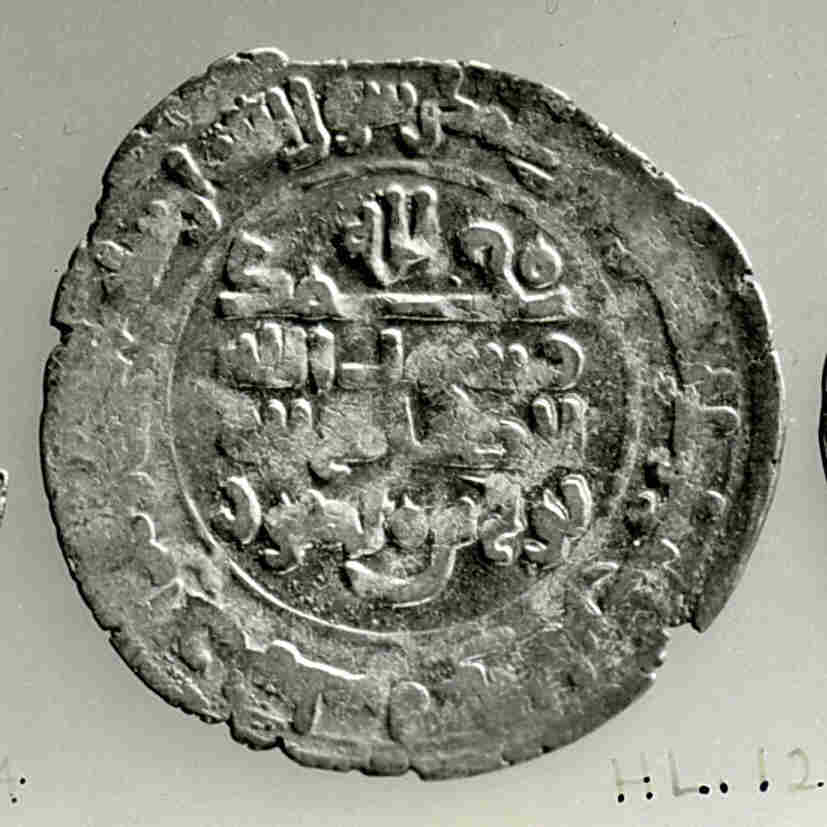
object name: coin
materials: silver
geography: iran